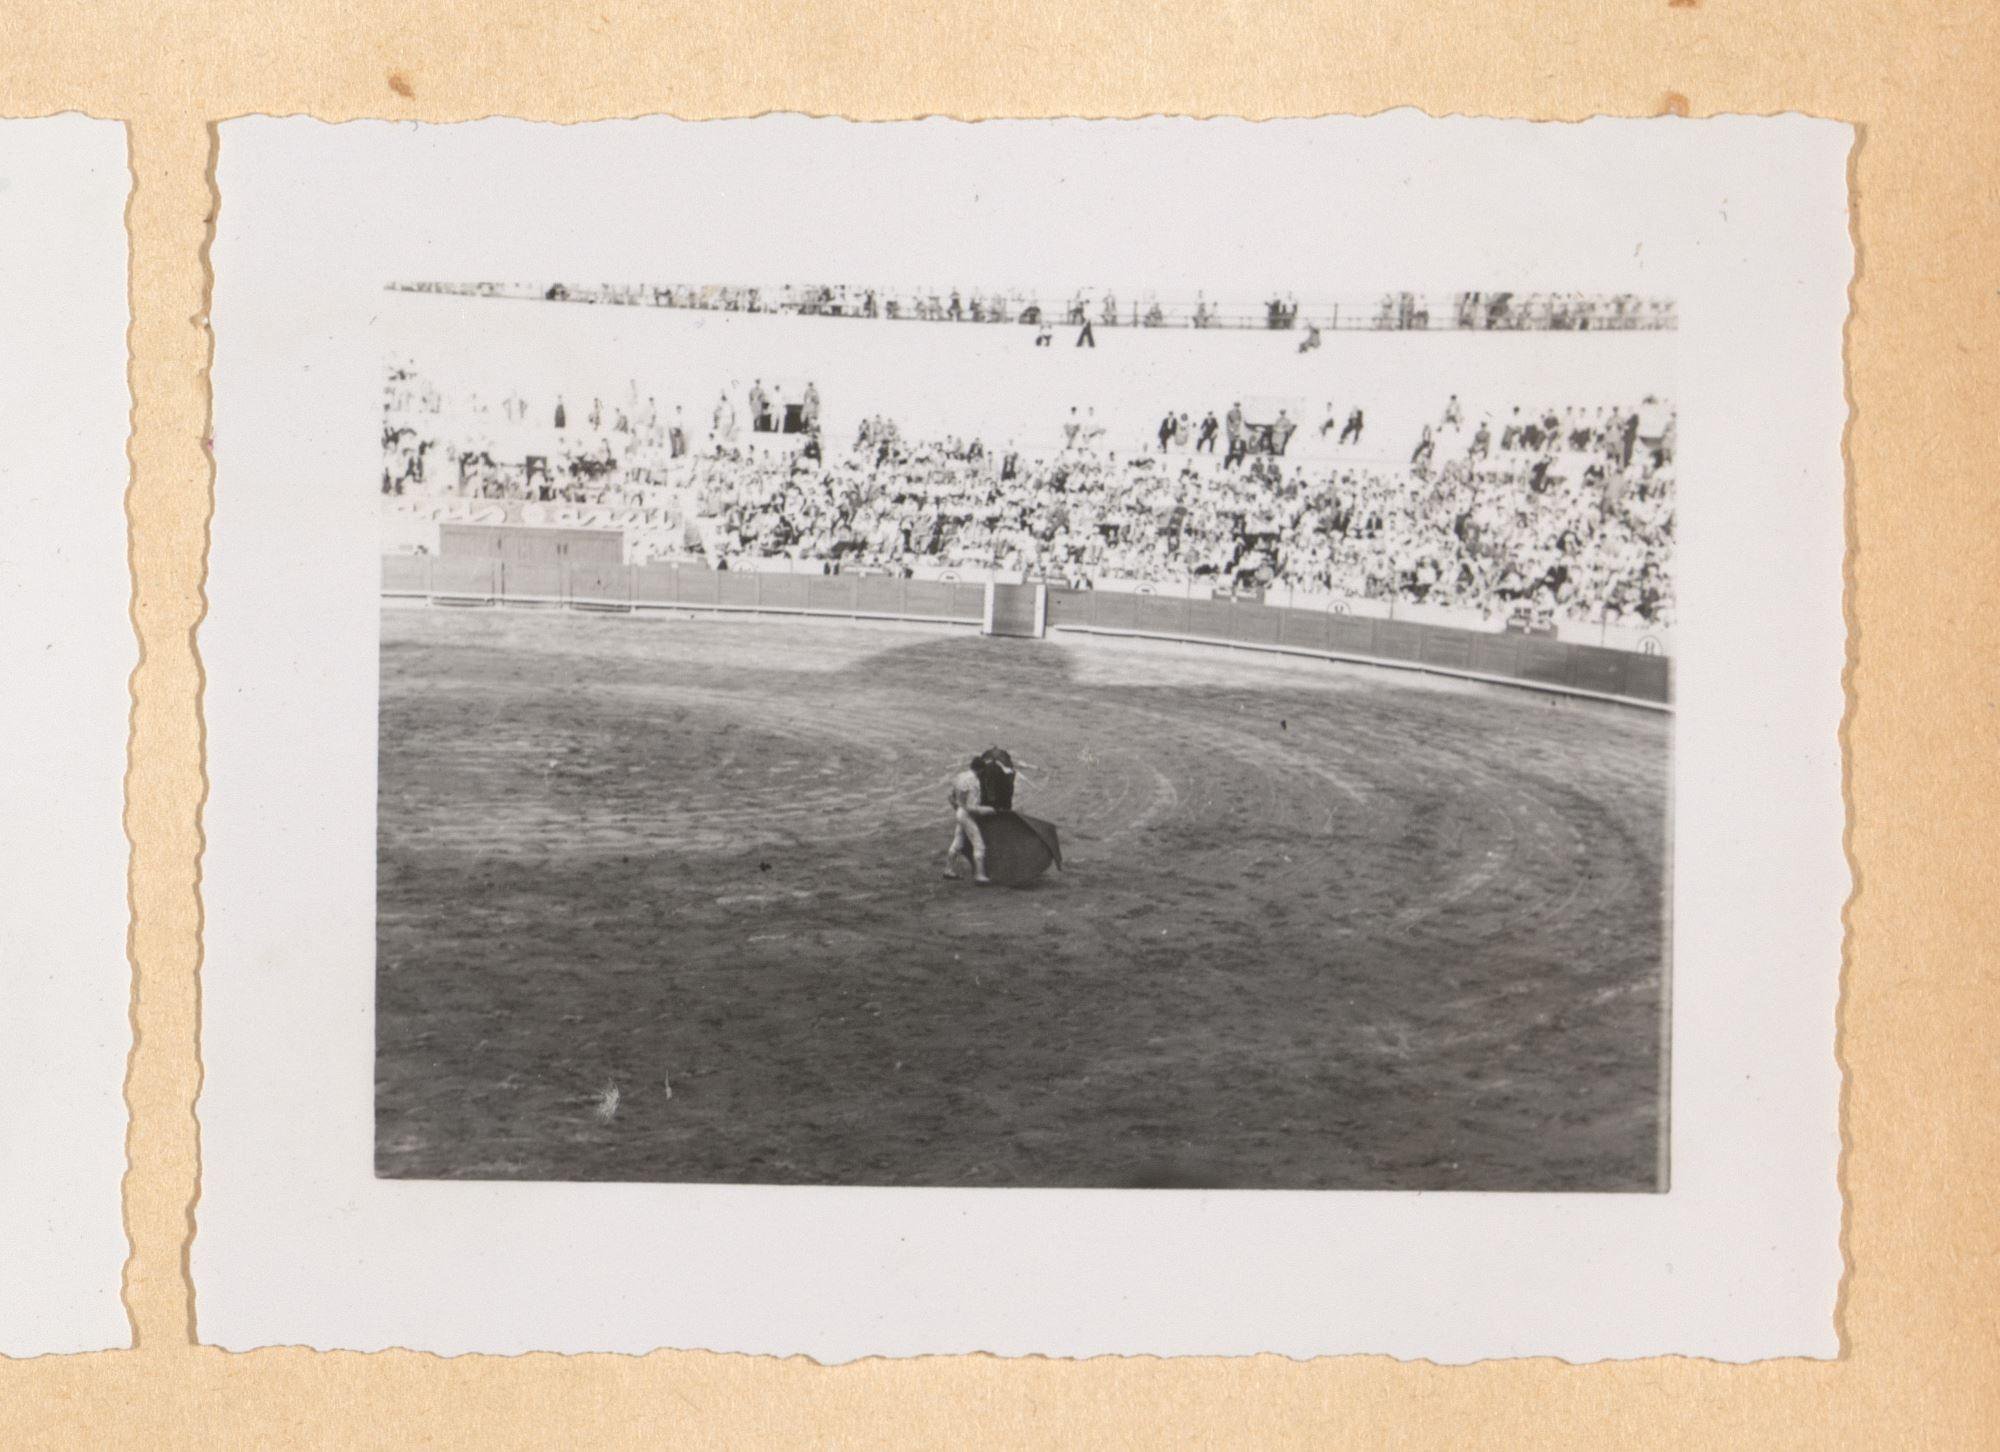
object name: album leaf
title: Jeu de la muleta et de l'epée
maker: Anonymous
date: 1955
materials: paper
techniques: gelatin silver print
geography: barcelona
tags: bull, bull-fighter, toreador